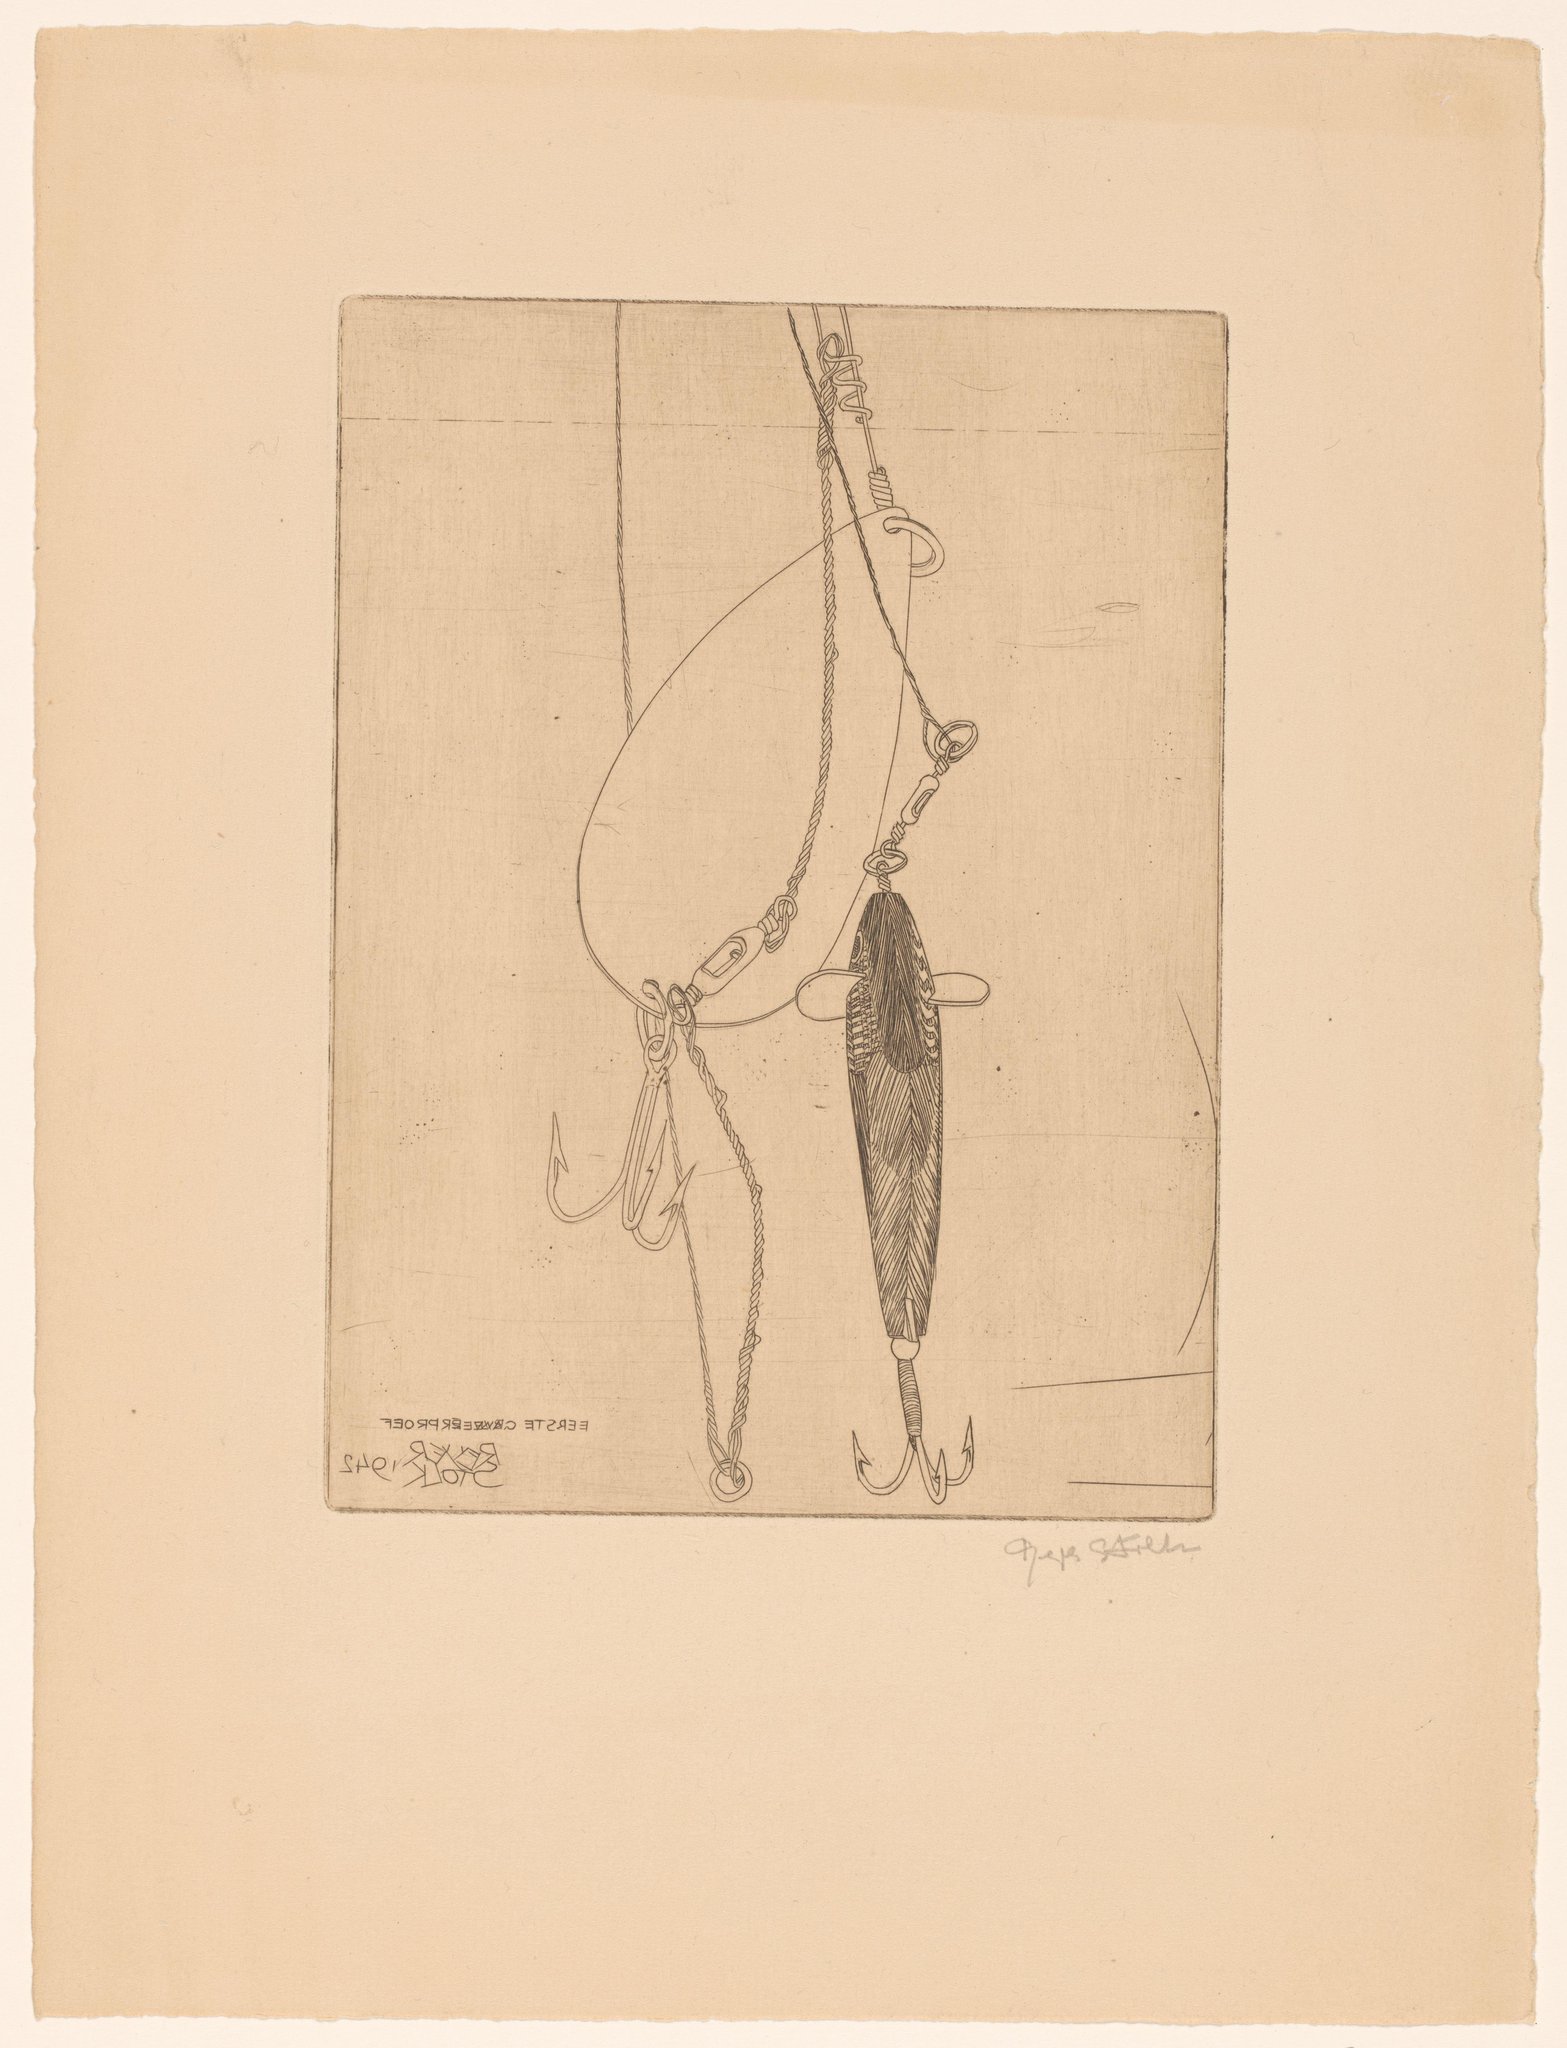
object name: print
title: Vishaken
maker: reijer stolk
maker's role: draughtsman, print maker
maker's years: 1896-1945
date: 1942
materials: paper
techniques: engraving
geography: netherlands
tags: fishing (sports) (+ fishing equipment)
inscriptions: collector's mark: Lugt 2228